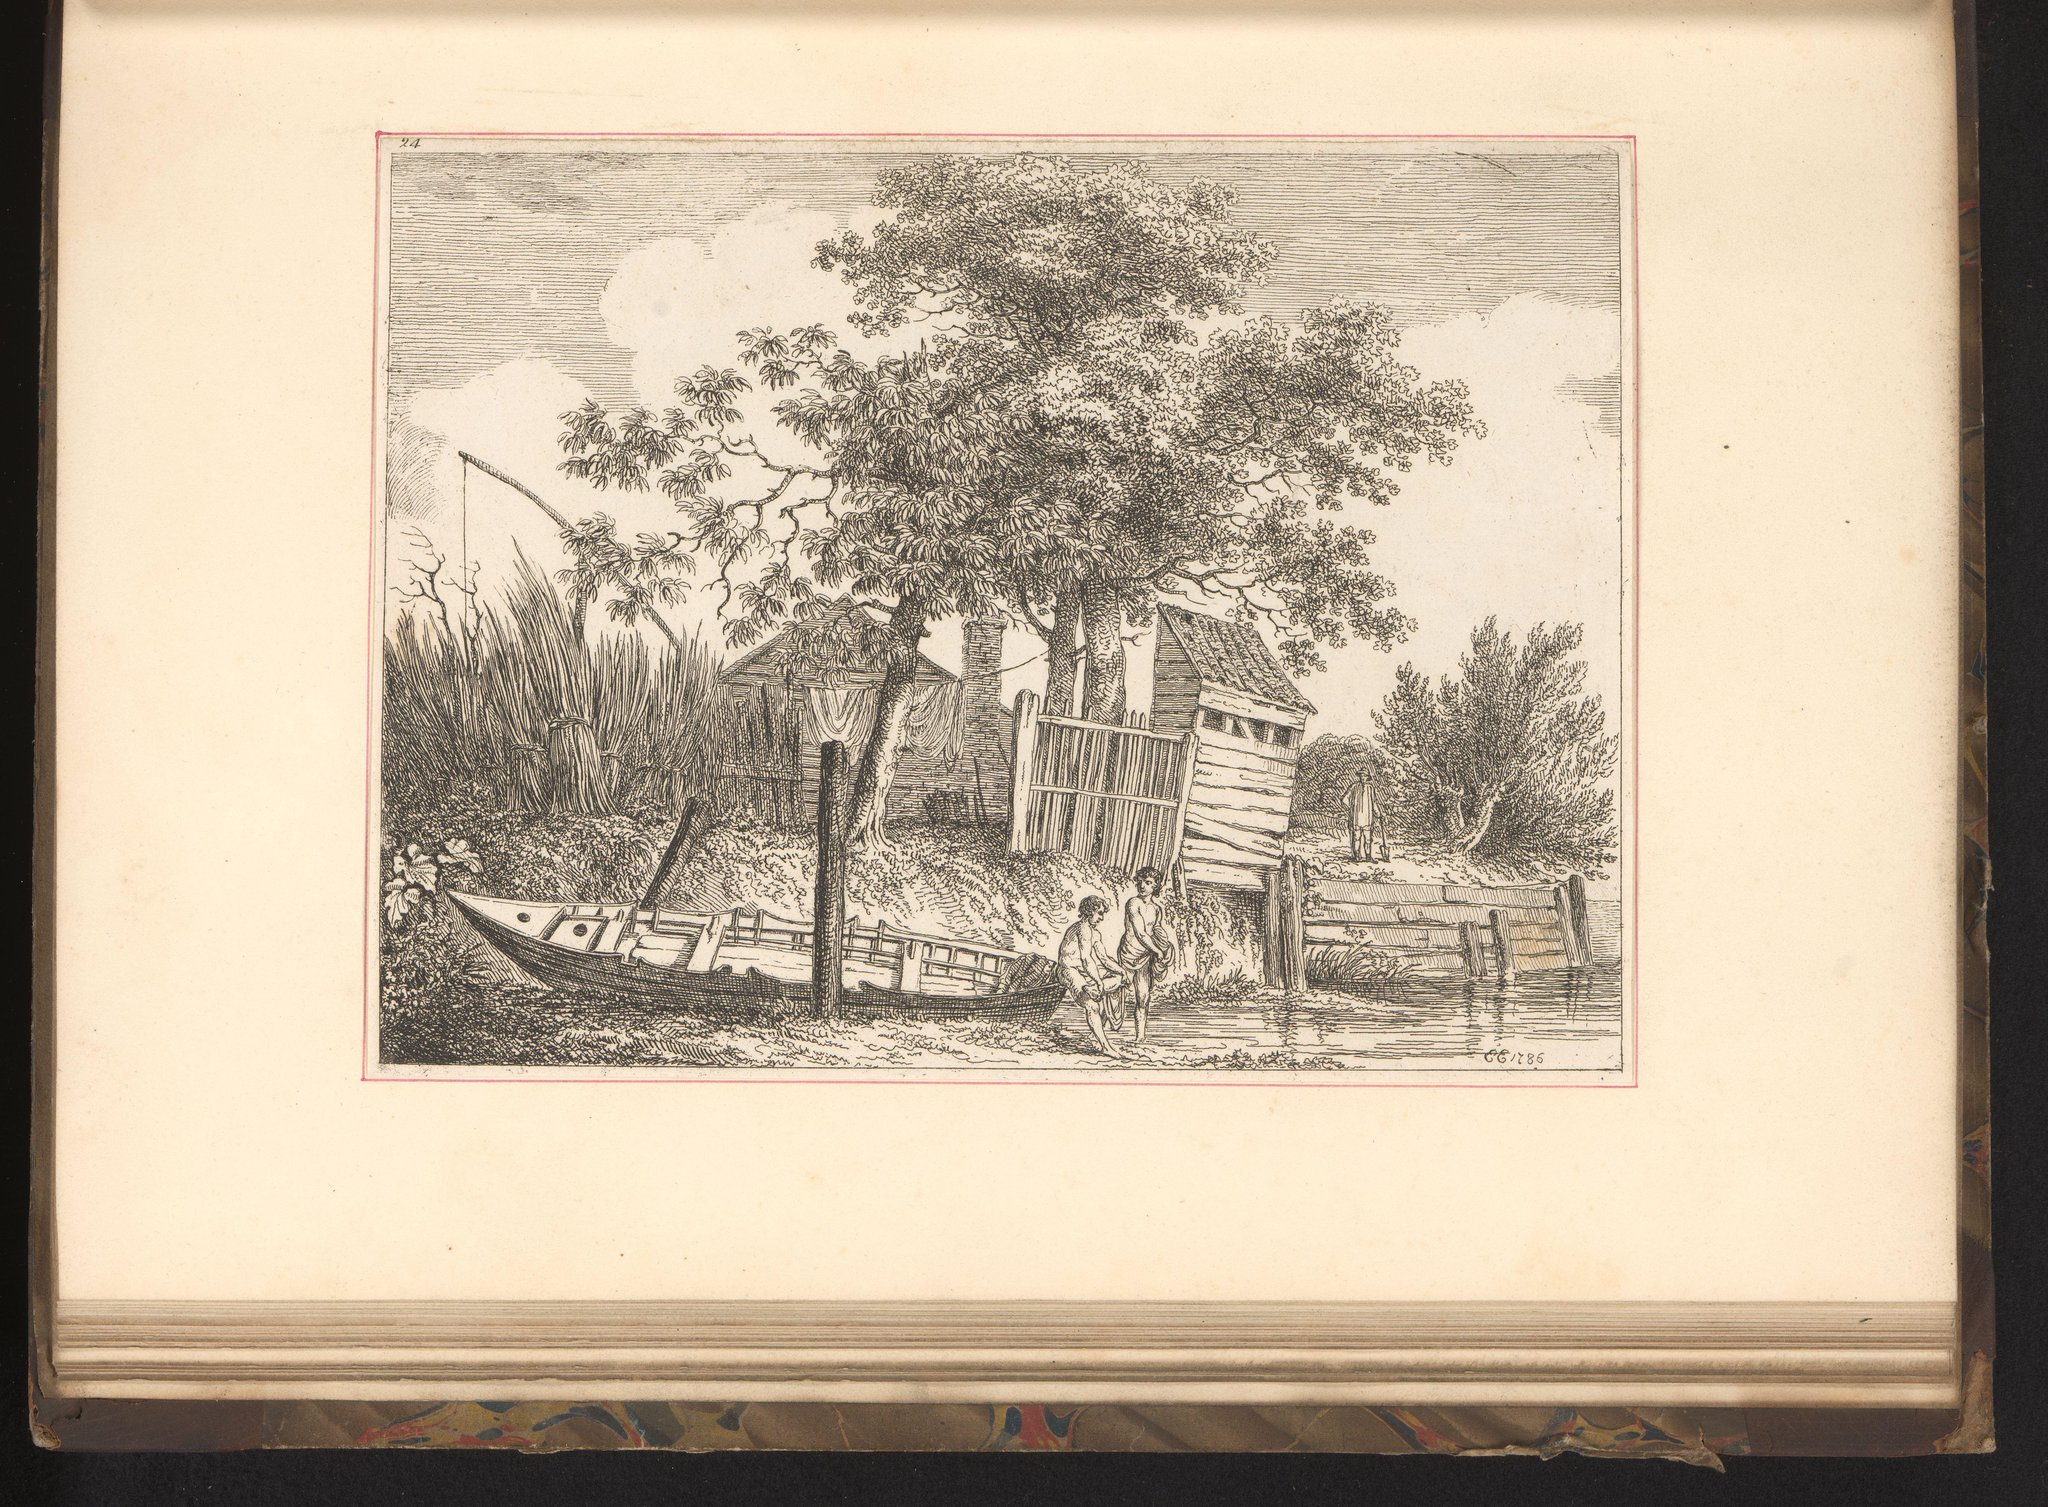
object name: album leaf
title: Etsen door E. Edwards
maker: edward edwards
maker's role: painter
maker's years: 1738-1806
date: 1786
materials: paper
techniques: etching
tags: taking a bath - aa - in the open air, landscapes (+ landscape with figures, staffage), farm (building)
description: Prent maakt deel uit van een serie van 51 prenten, bestaande uit twee delen met landschappen (36 prenten) en figuren en portretten (15 prenten), voor het eerst uitgegeven in Londen in 1790.